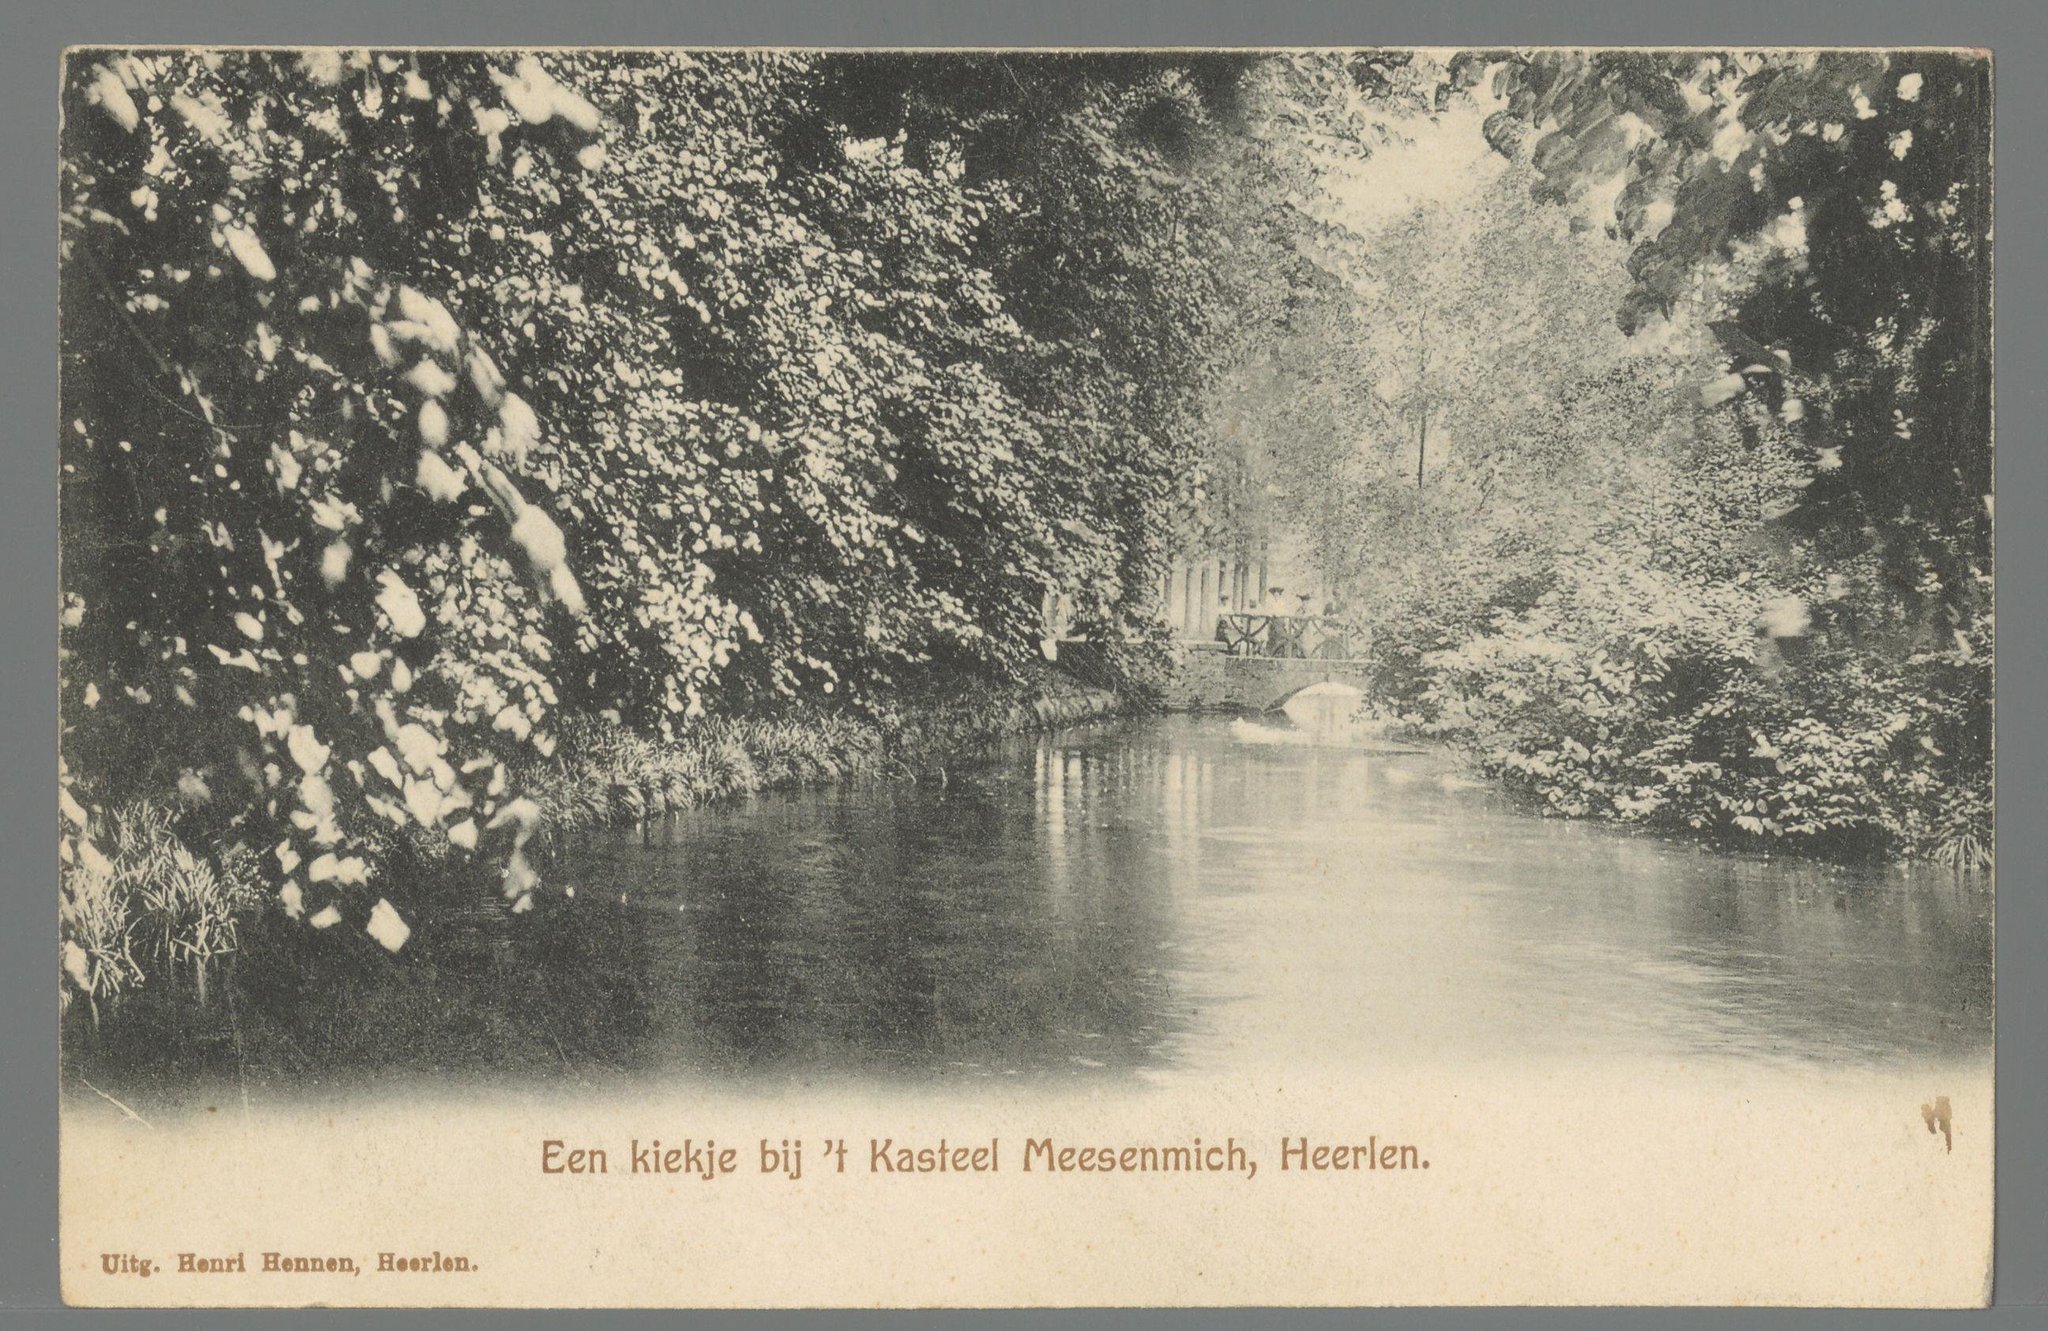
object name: ansichtkaart, prentbriefkaart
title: Een kiekje bij 't Kasteel Meesenmich, Heerlen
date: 1897-1905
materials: cardboard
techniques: photograph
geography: heerlen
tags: canal, bridge